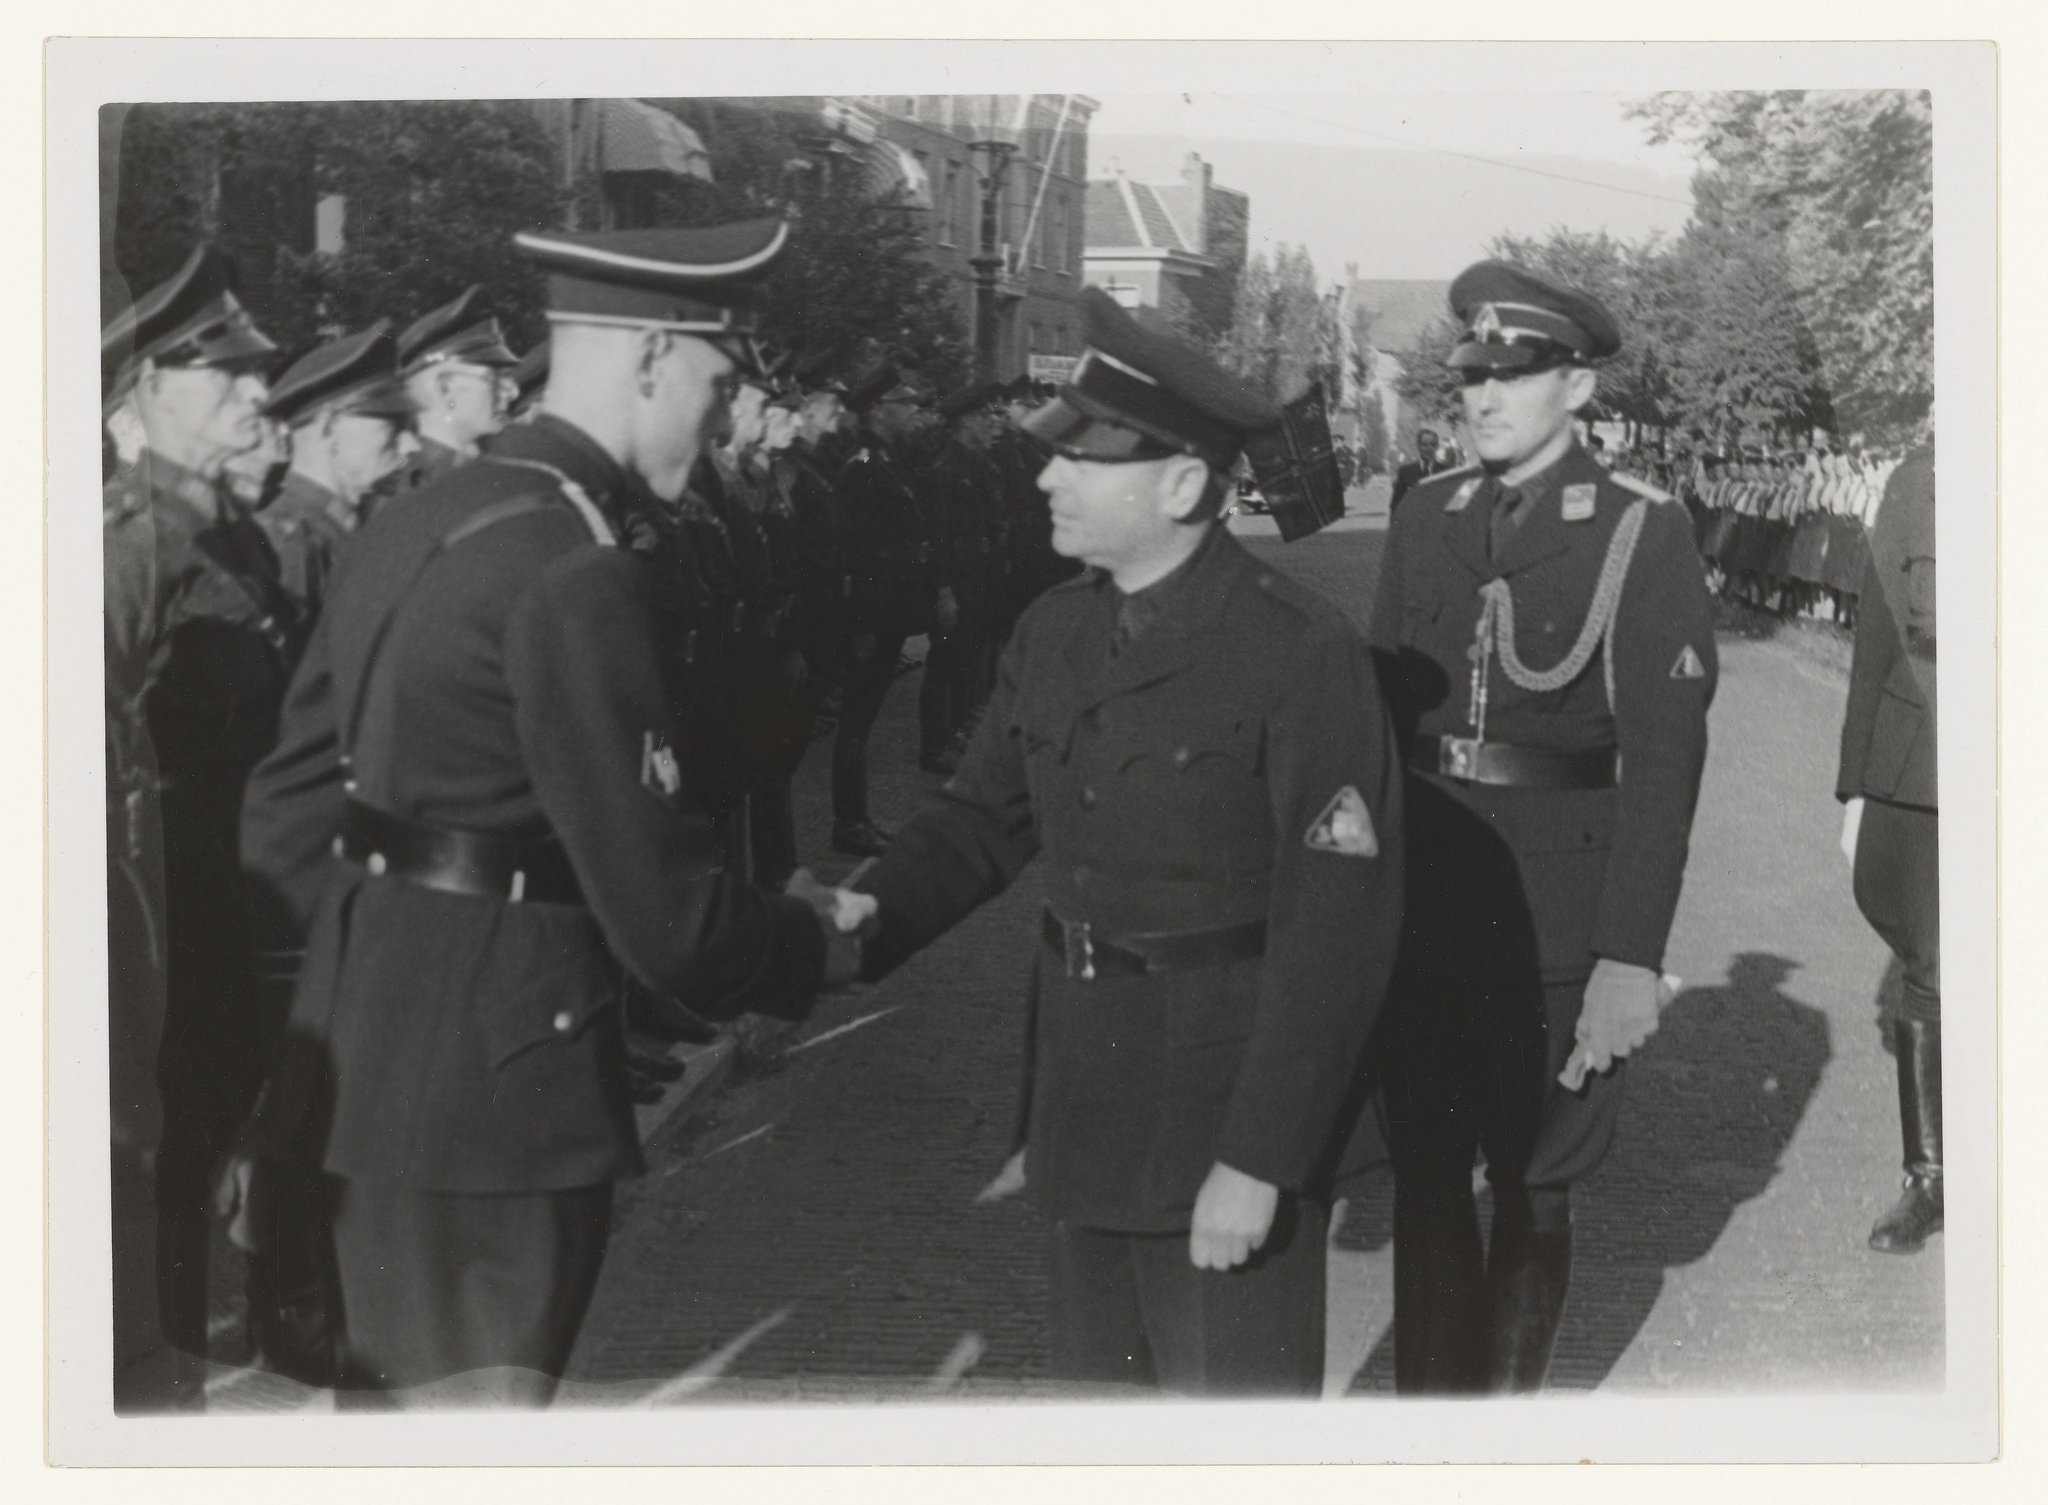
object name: photograph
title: NSB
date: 1941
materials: photographic support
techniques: photography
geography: haarlem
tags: the hague, politician, anton adriaan mussert, military celebrations, haarlem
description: Mussert groet de Nederlandse SSer W.J. Heubel tijdens de opening van een districtshuis in Haarlem. Hij was de broer van Fl. Rost van Tonningen, de Zwarte Weduwe. Heubel diende vanaf 1941 in de SS en sneuvelde in april 1945 in Nederland in een gevecht met de Canadezen. Rechts achter Mussert zijn adjudant Van den Arend.